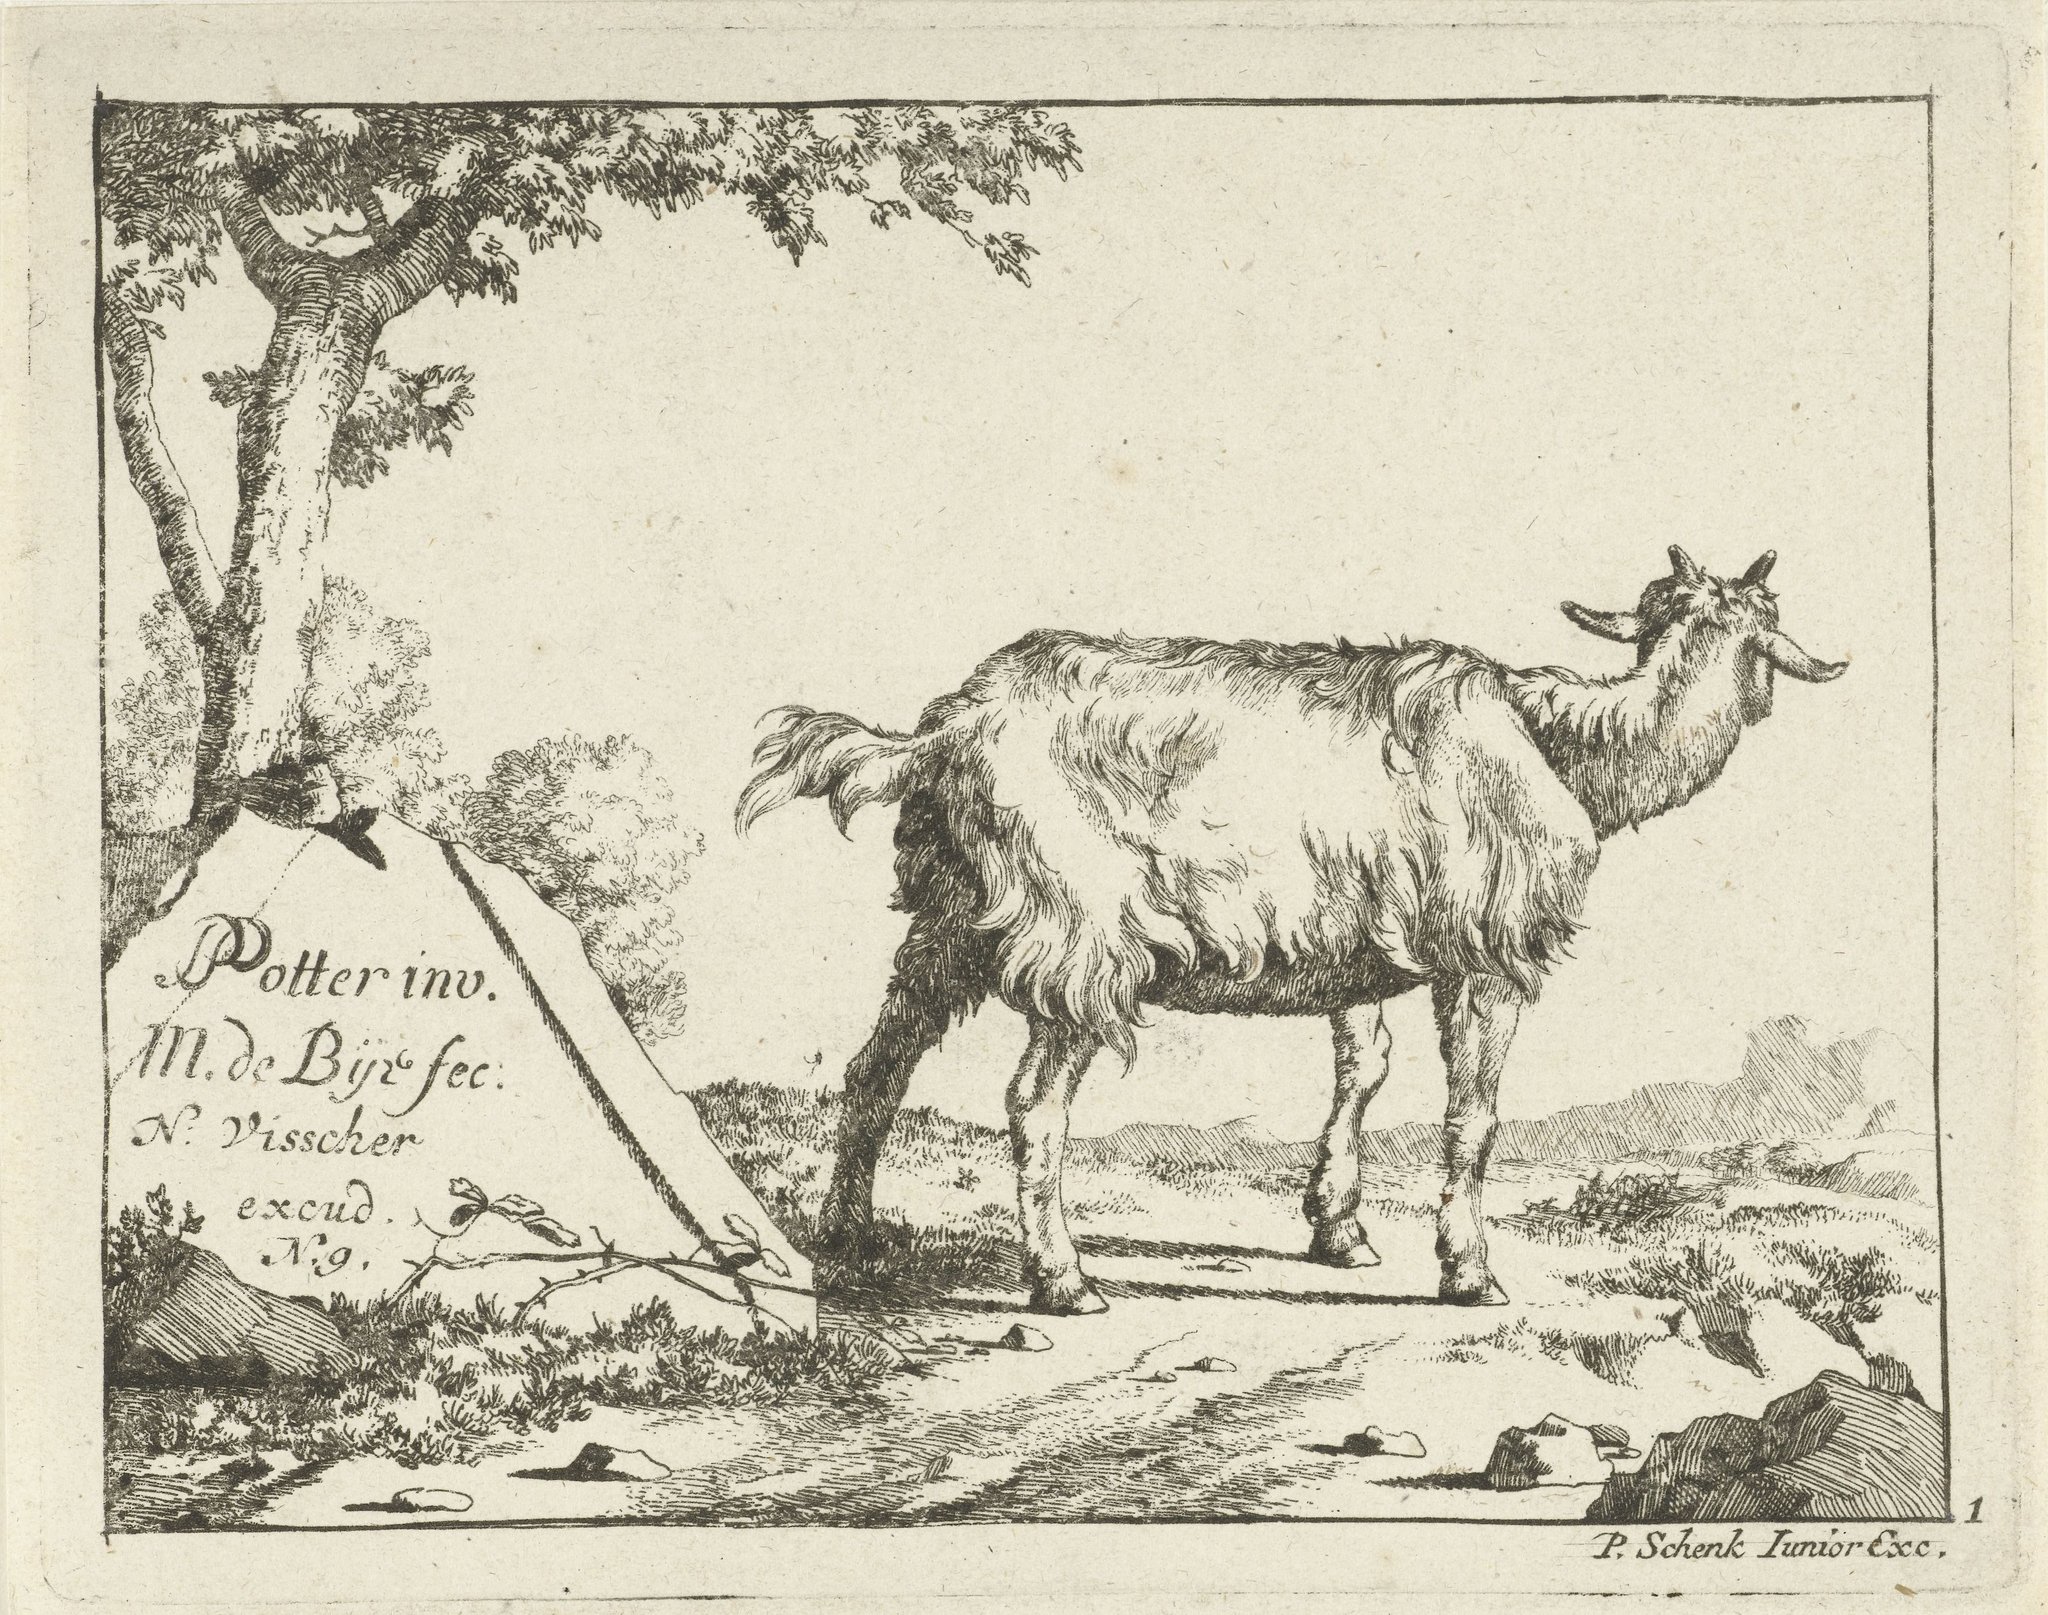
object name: titelprent, frontispice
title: Staande geit van achter gezien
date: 1728-1761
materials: paper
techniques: etching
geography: amsterdam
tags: goat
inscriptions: collector's mark: Lugt 2228